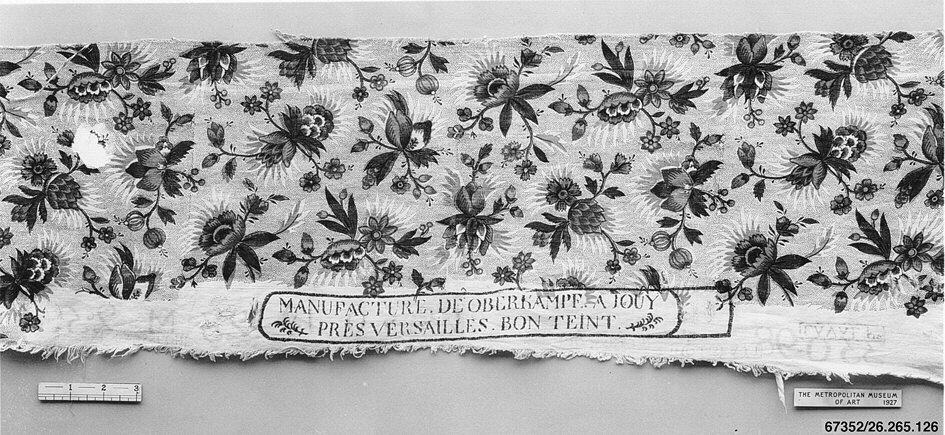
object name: floral print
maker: oberkampf manufactory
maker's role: manufactory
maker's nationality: french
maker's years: 1760-1843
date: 1767-1800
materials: linen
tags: flowers,leaves